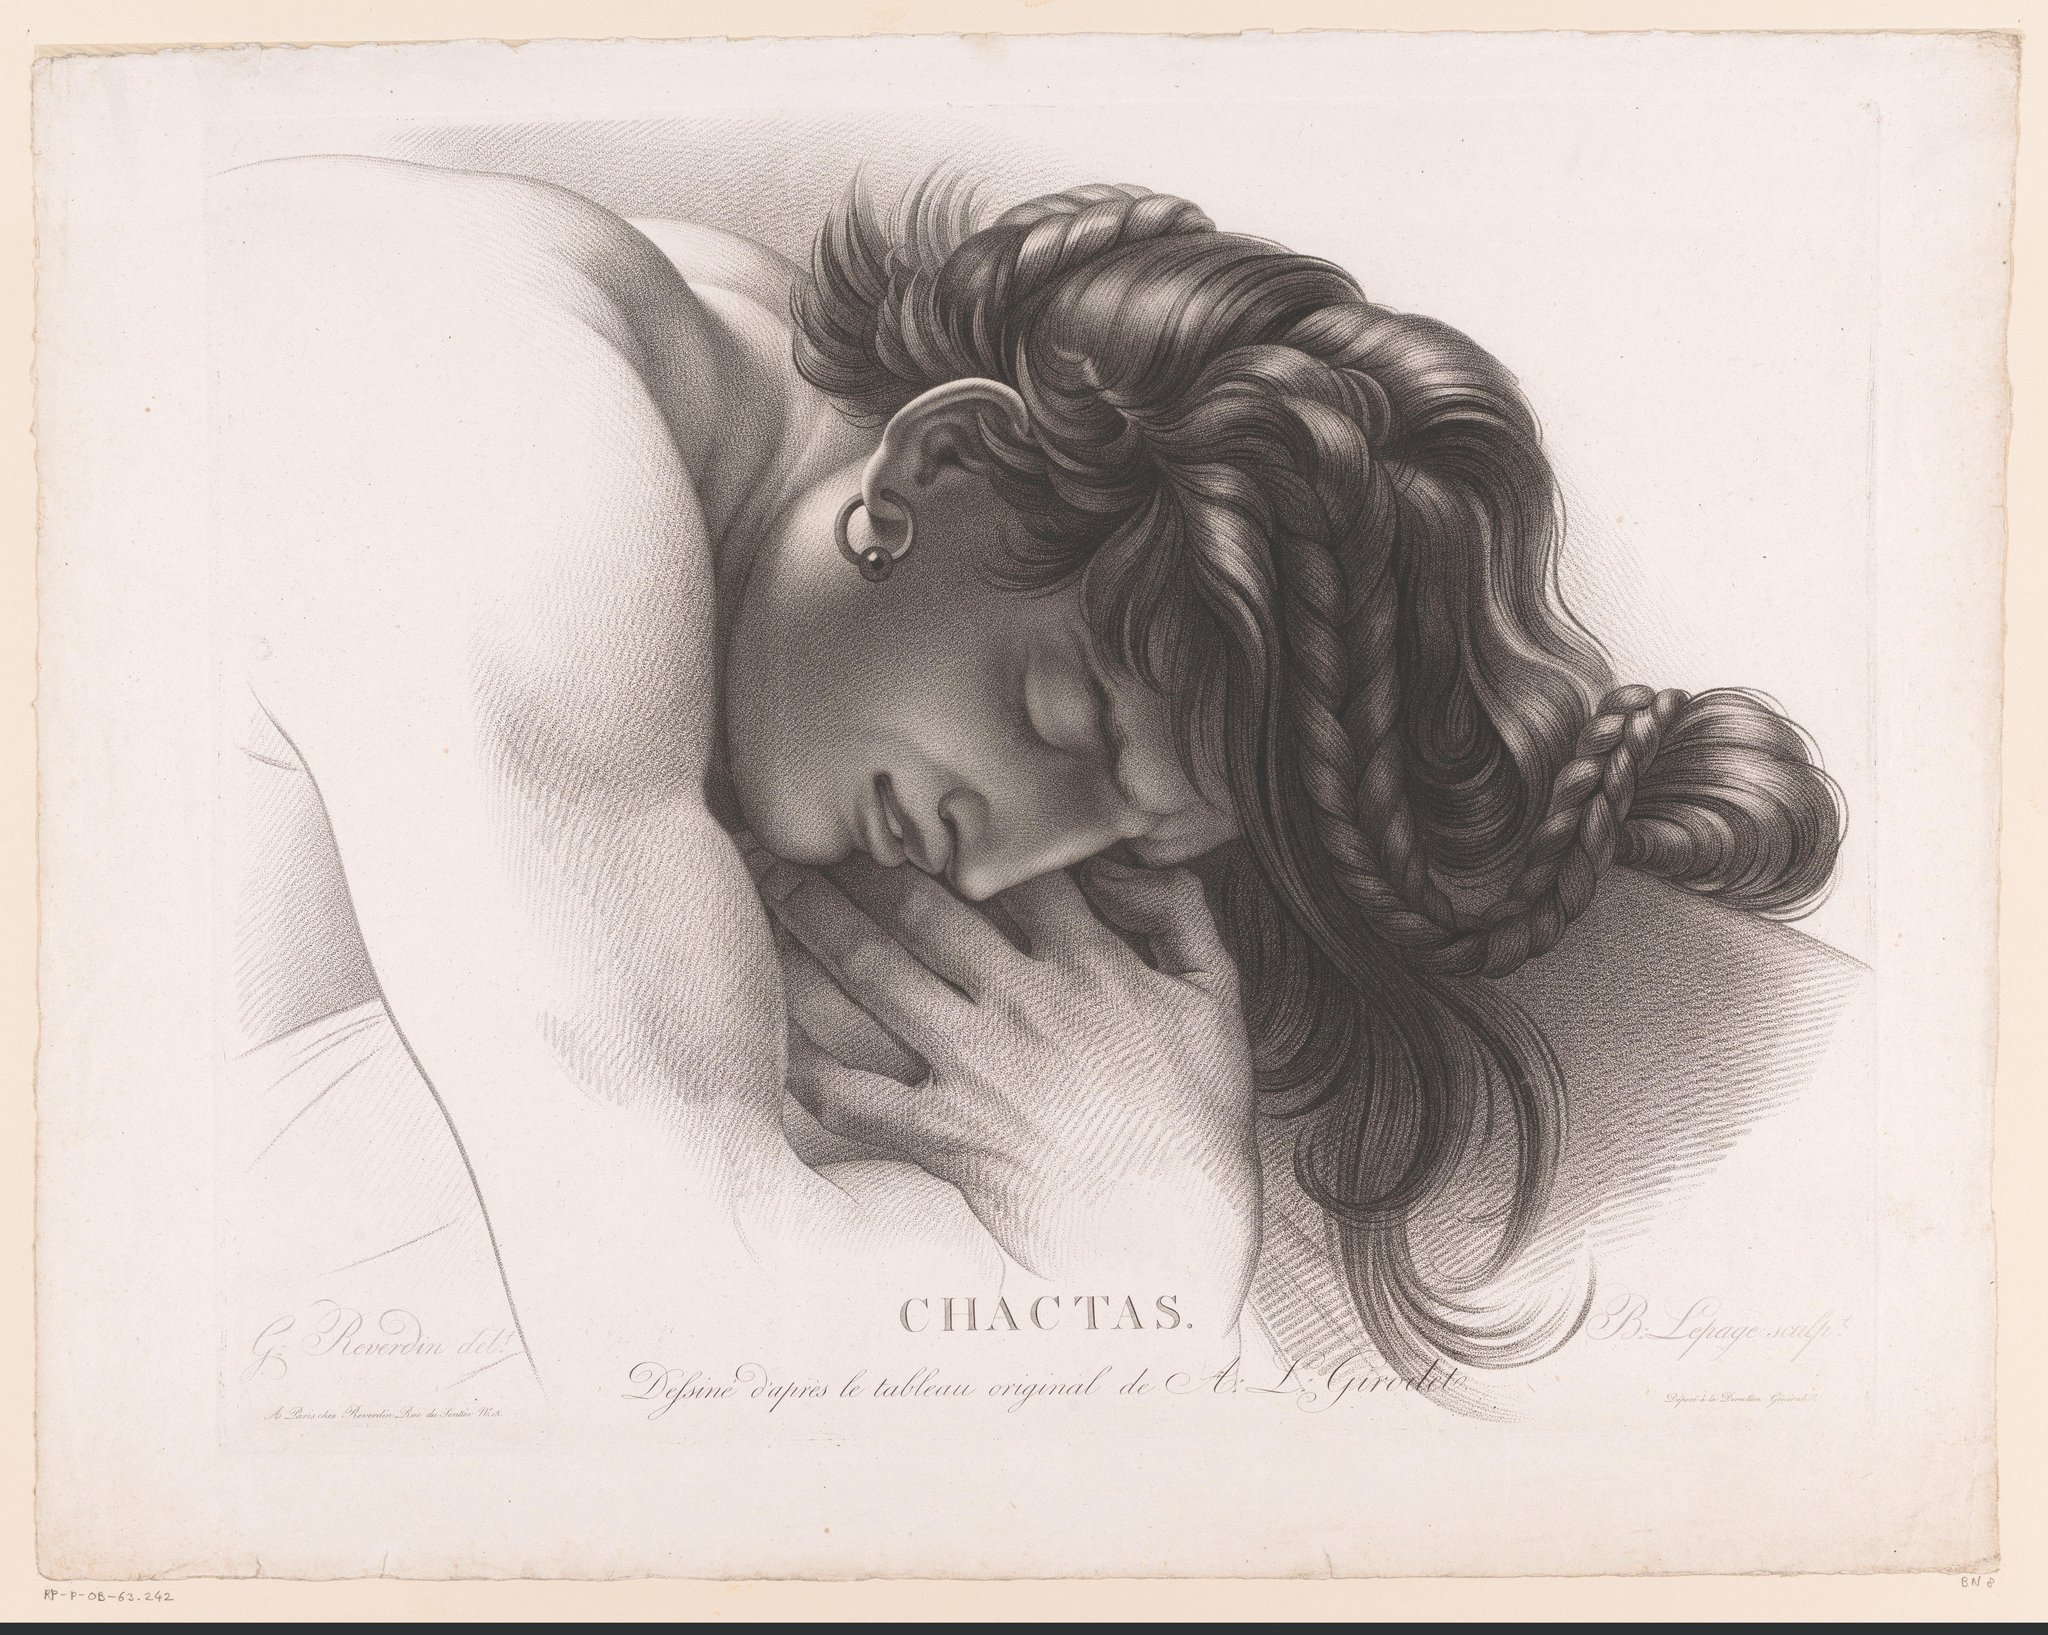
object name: print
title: Chactas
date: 1812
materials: paper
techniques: printmaking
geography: france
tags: mourning customs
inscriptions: : ‘Déposé à la Direction Générale.’, collector's mark: Lugt 2228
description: Het schilderij bevindt zich in de collectie van het Musée du Louvre te Parijs, inv.nr. 1990.1.